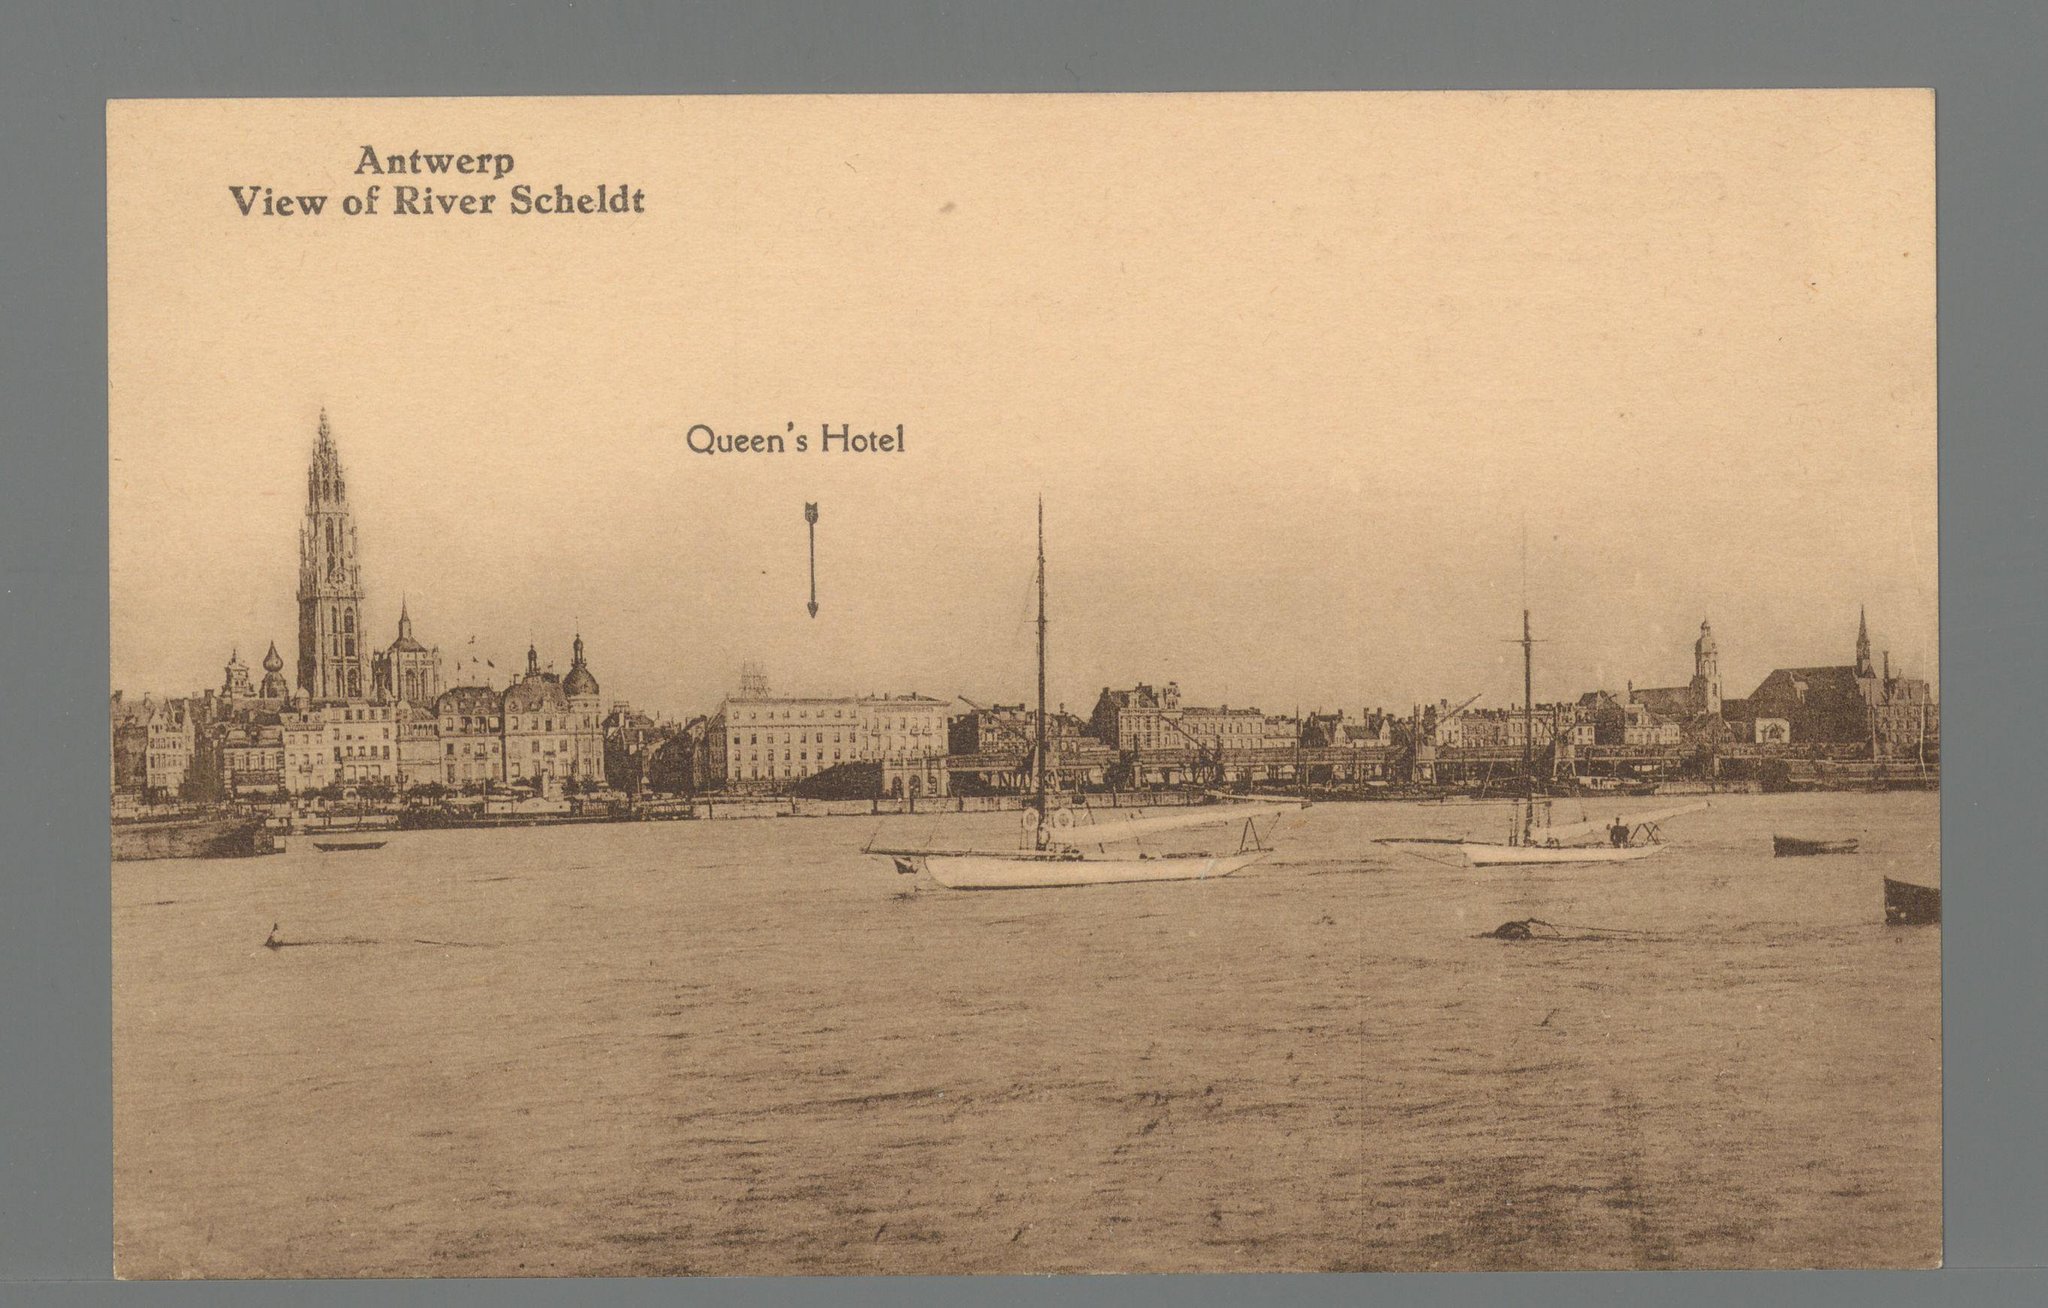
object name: ansichtkaart, prentbriefkaart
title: Queen's Hotel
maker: Anonymous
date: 1906-1930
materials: cardboard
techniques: photograph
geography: antwerp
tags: city-view, and landscape with man-made constructions, river, ships (in general), antwerp